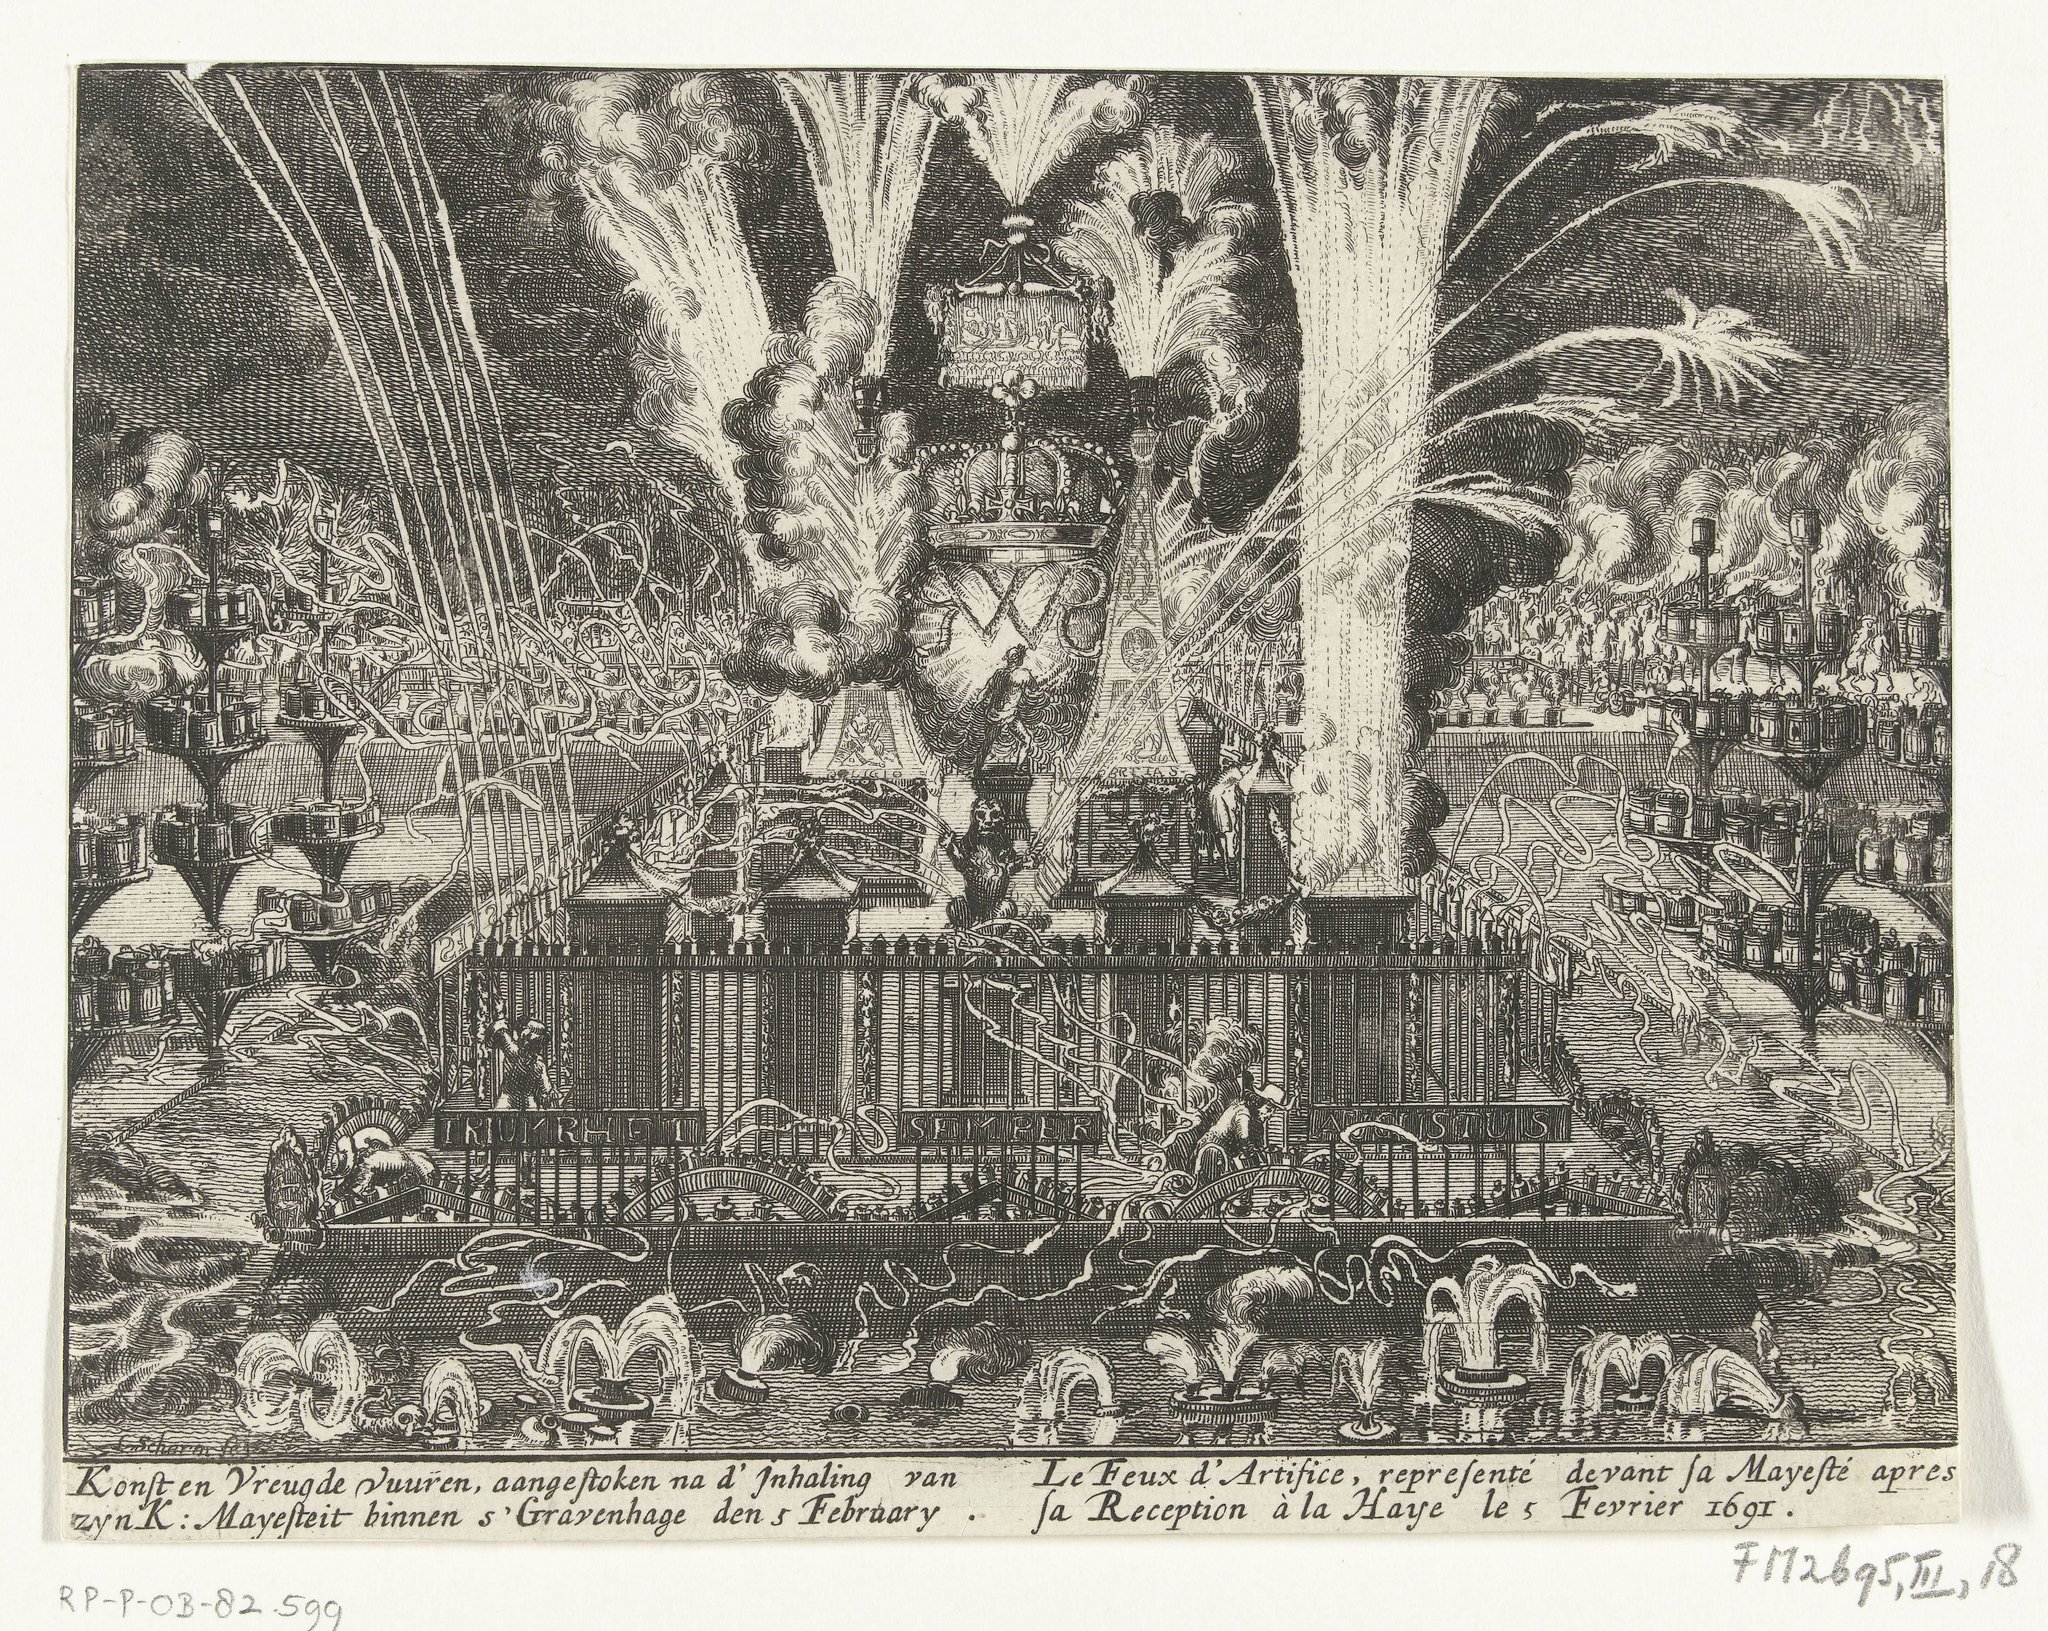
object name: print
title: Engelands schouwtoneel verbeeldende de voornaamste voorvallen in Yrland van 't Jaar 1690 tot de velttogt van S:K: Mayesteit van Groot Brittanie 1691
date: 1691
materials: paper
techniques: etching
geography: amsterdam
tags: the hague, william iii (prince of orange and king of england, scotland, and ireland), bonfire, fire-works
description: Vuurwerk afgestoken op het water ter gelegenheid van de intocht van koning Willem III te Den Haag, 5 februari 1691. Plaat nr. 18 in de serie 'Engelands schouwtoneel' over de oorlog tussen Willem III en Jacobus II in de jaren 1690-1691 na de Glorious Revolution, (derde deel). Met onderschriften in het Nederlands en Frans.